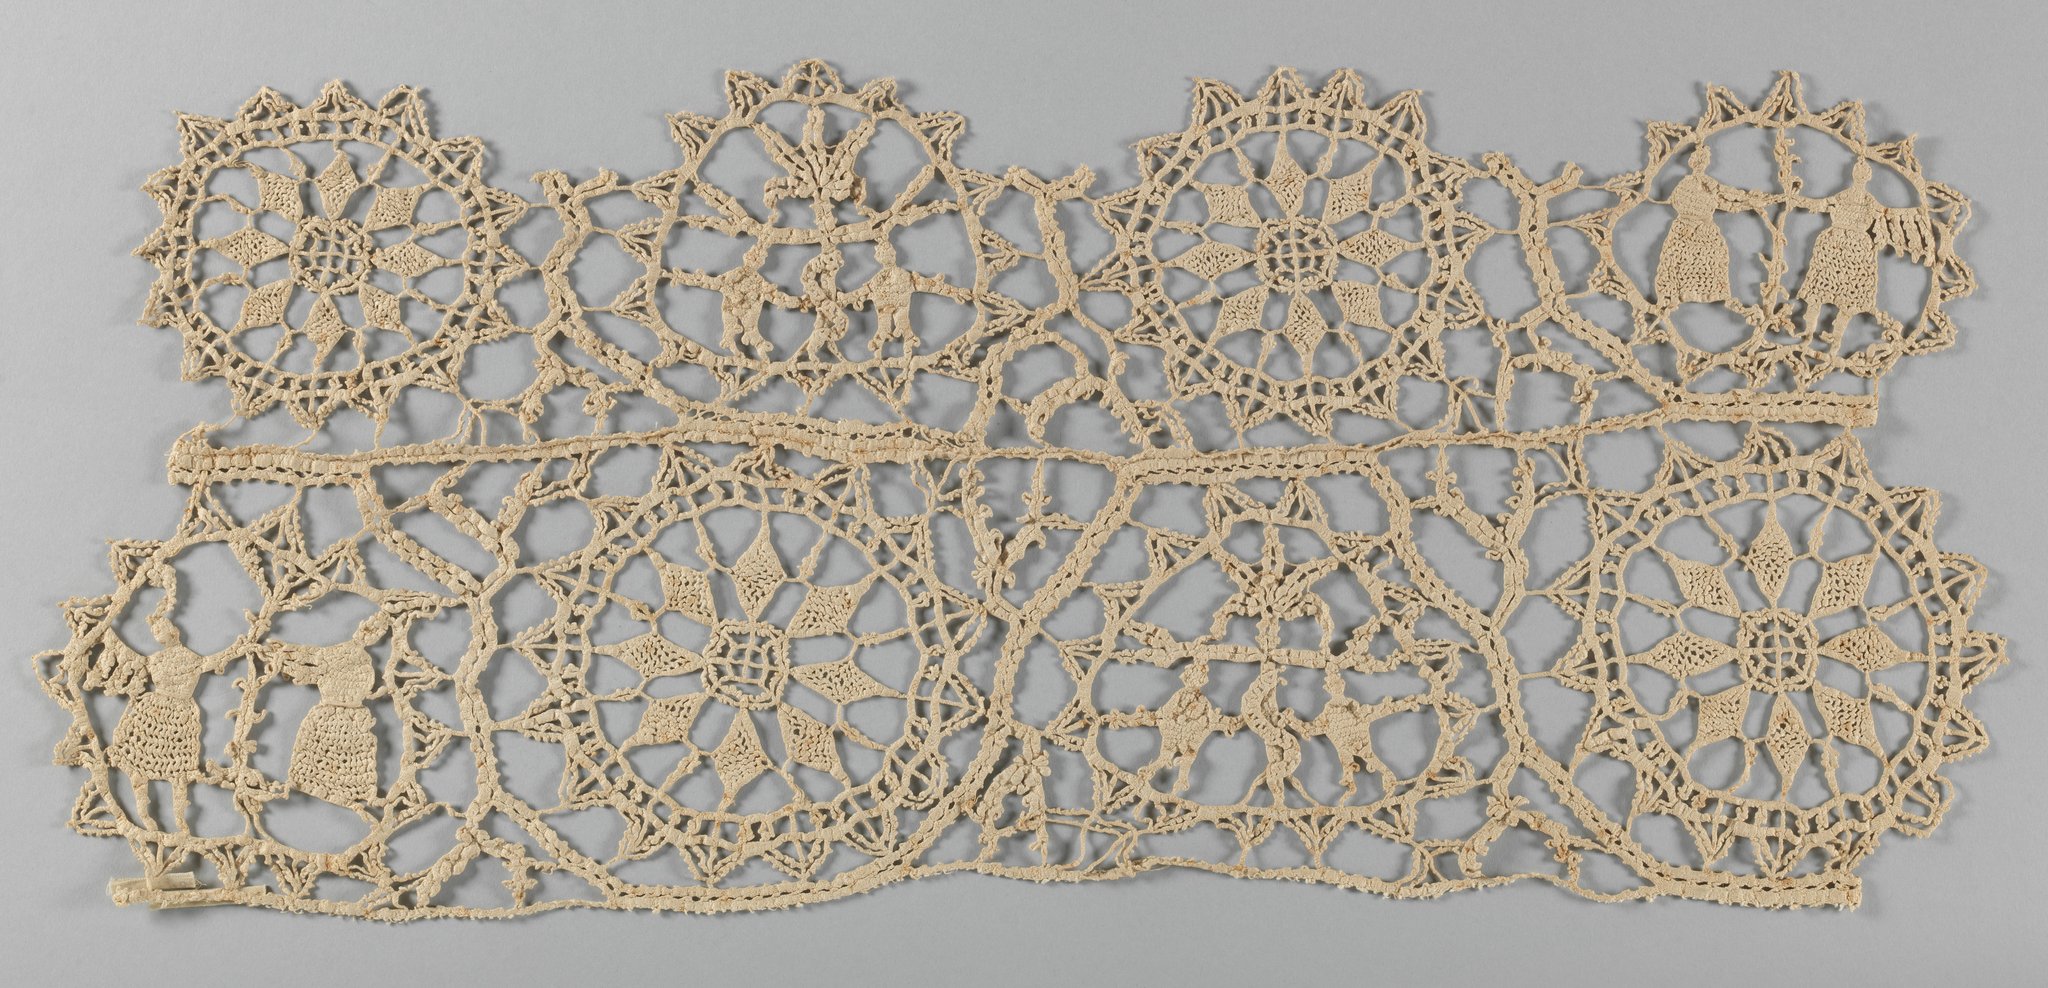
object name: border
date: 1600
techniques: lace